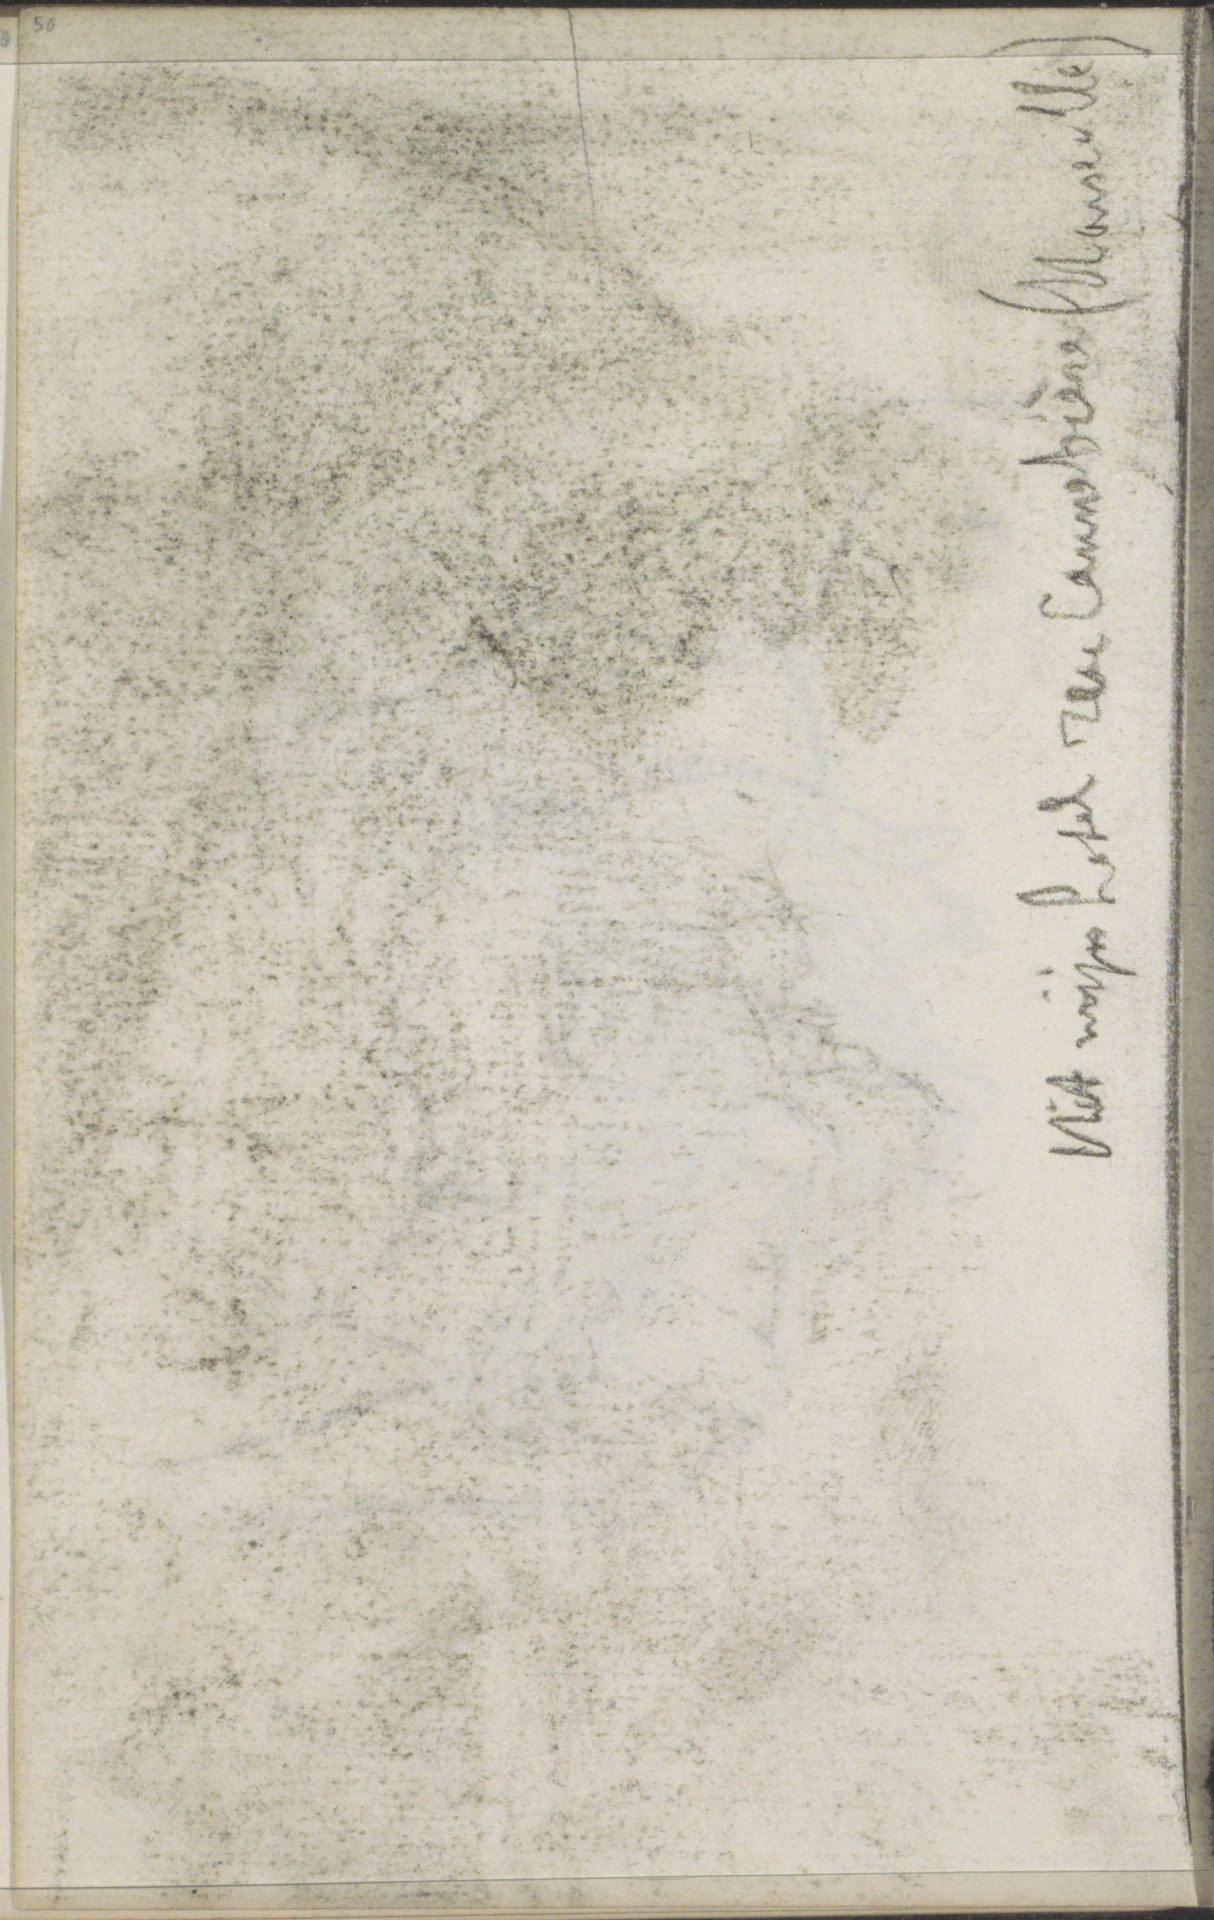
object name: sketchbook leaf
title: Blad met notitie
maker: marius bauer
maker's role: draughtsman, print maker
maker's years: 1867-1932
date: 1899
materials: chalk, paper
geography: marseille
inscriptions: annotation: ‘[...] hotel rue Cannebière (Marseille)’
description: De notitie verwijst naar de schets op pagin 51. Pagina 50 uit een schetsboek met 42 bladen.